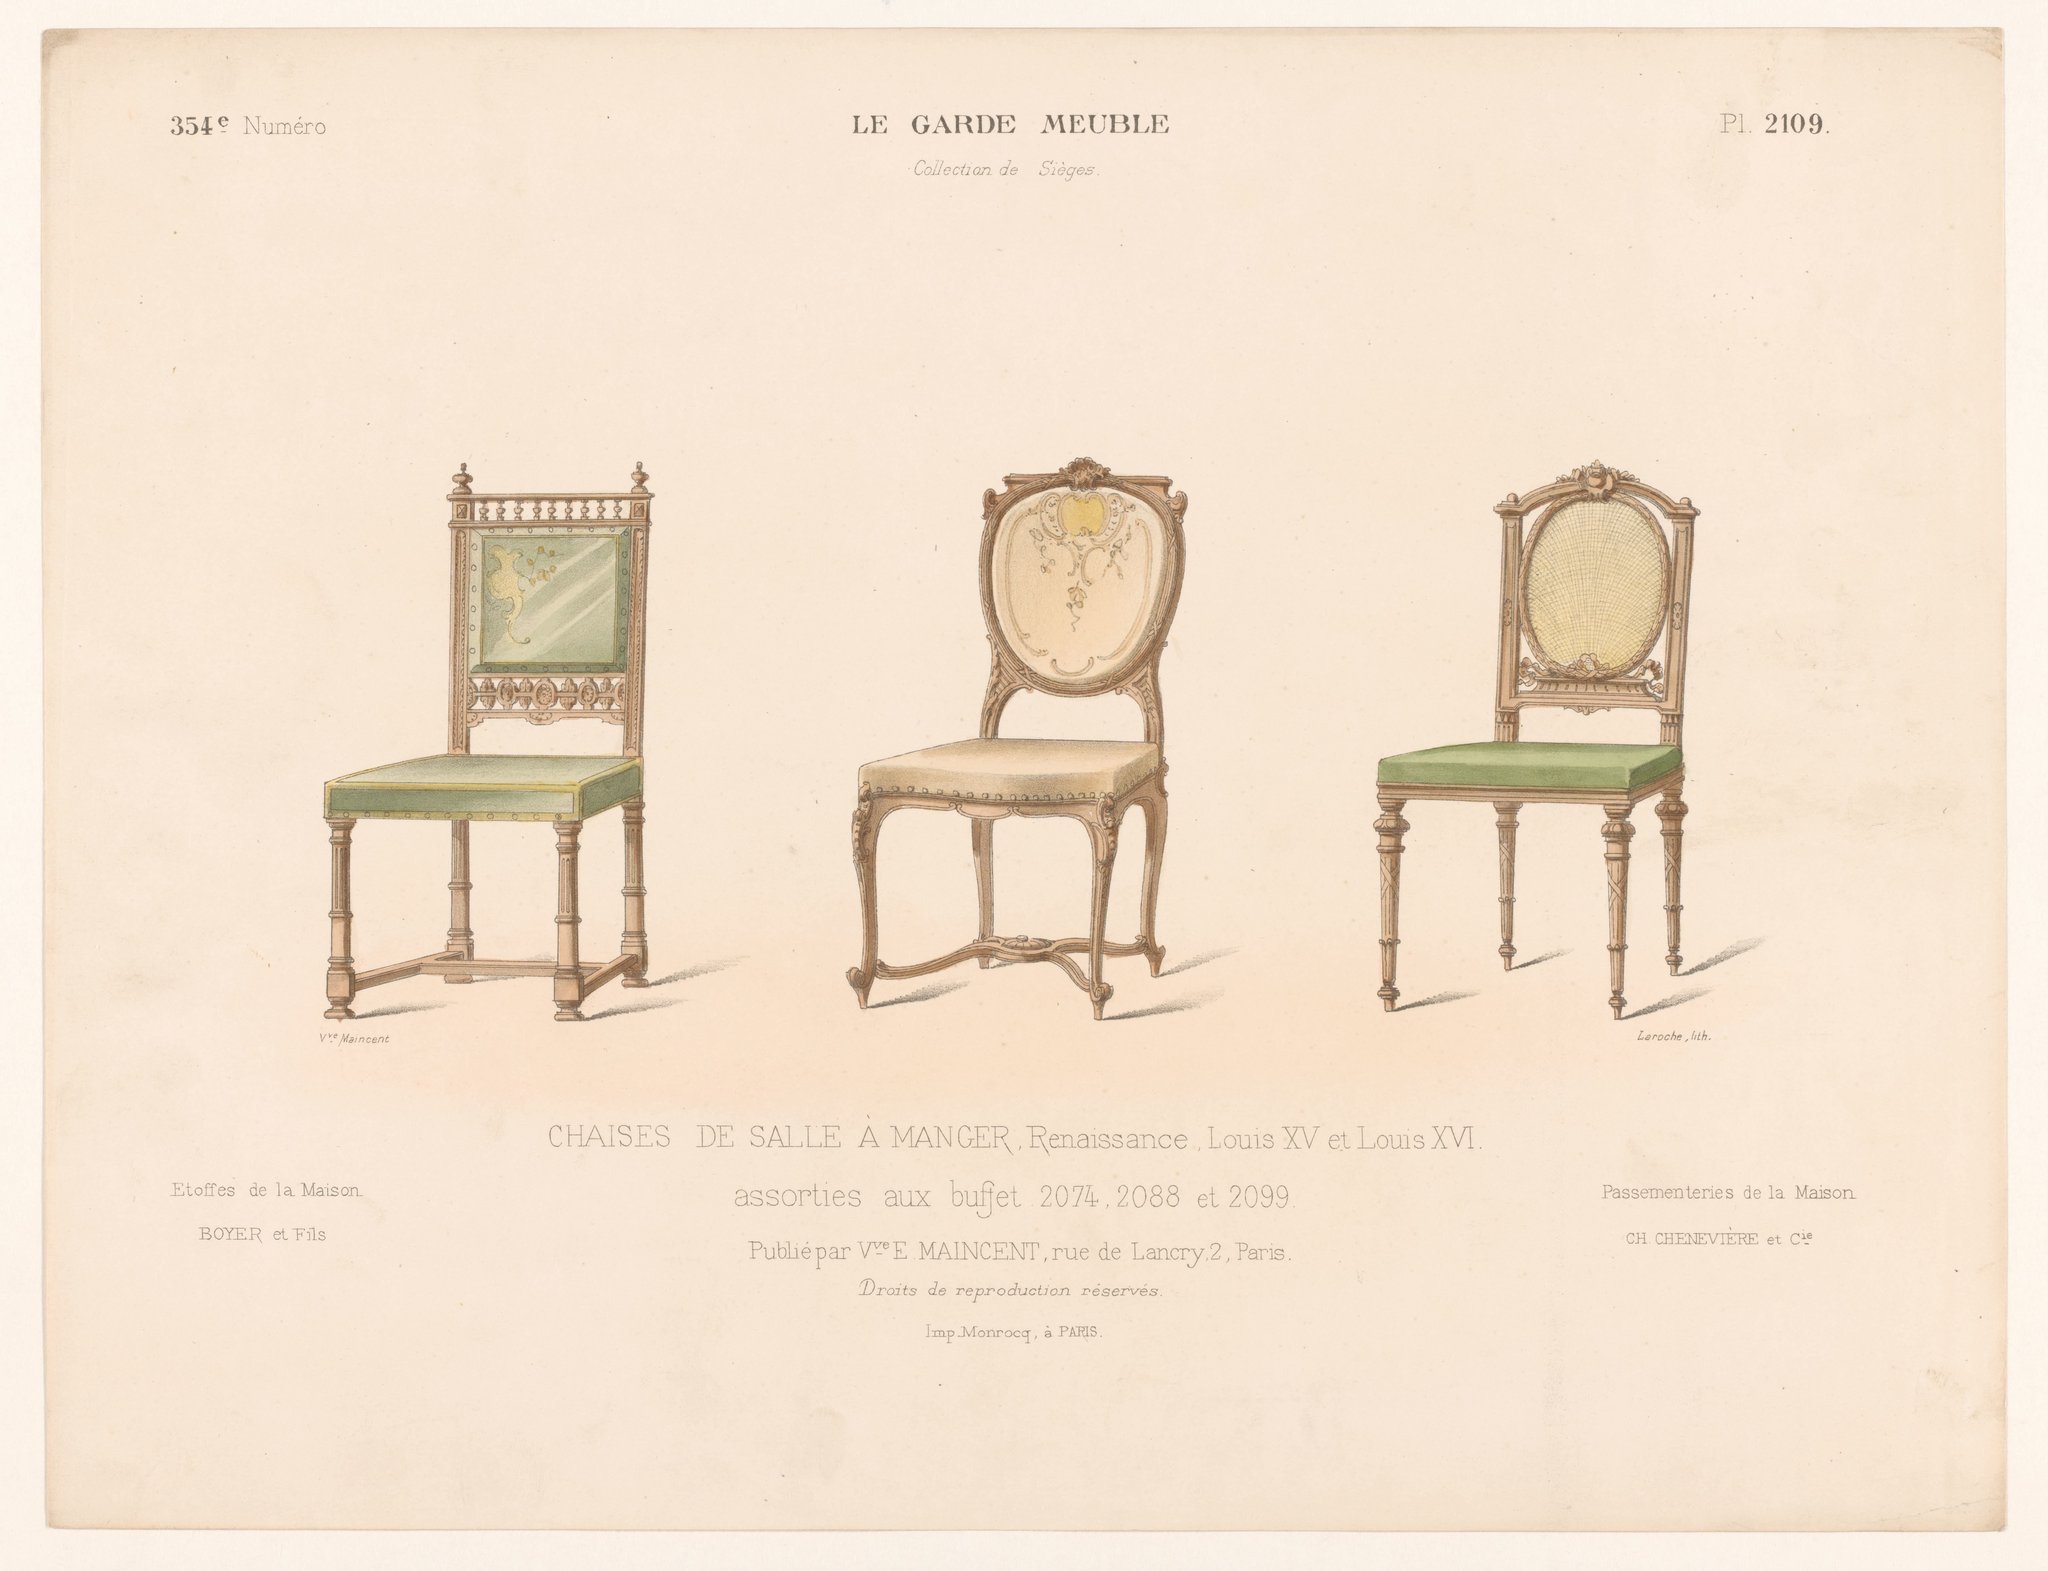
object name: print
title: Drie eetkamerstoelen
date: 1895-1935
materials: paper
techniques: hand coloring, lithograph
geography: paris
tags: seating furniture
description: Ieder Livraison in de serie Le Garde-Meuble bevat negen platen: drie 'sièges' (zitmeubels), drie 'meubles' (diverse meubels zoals tafels en kasten) en drie 'tentures' (gordijnen en draperieën).